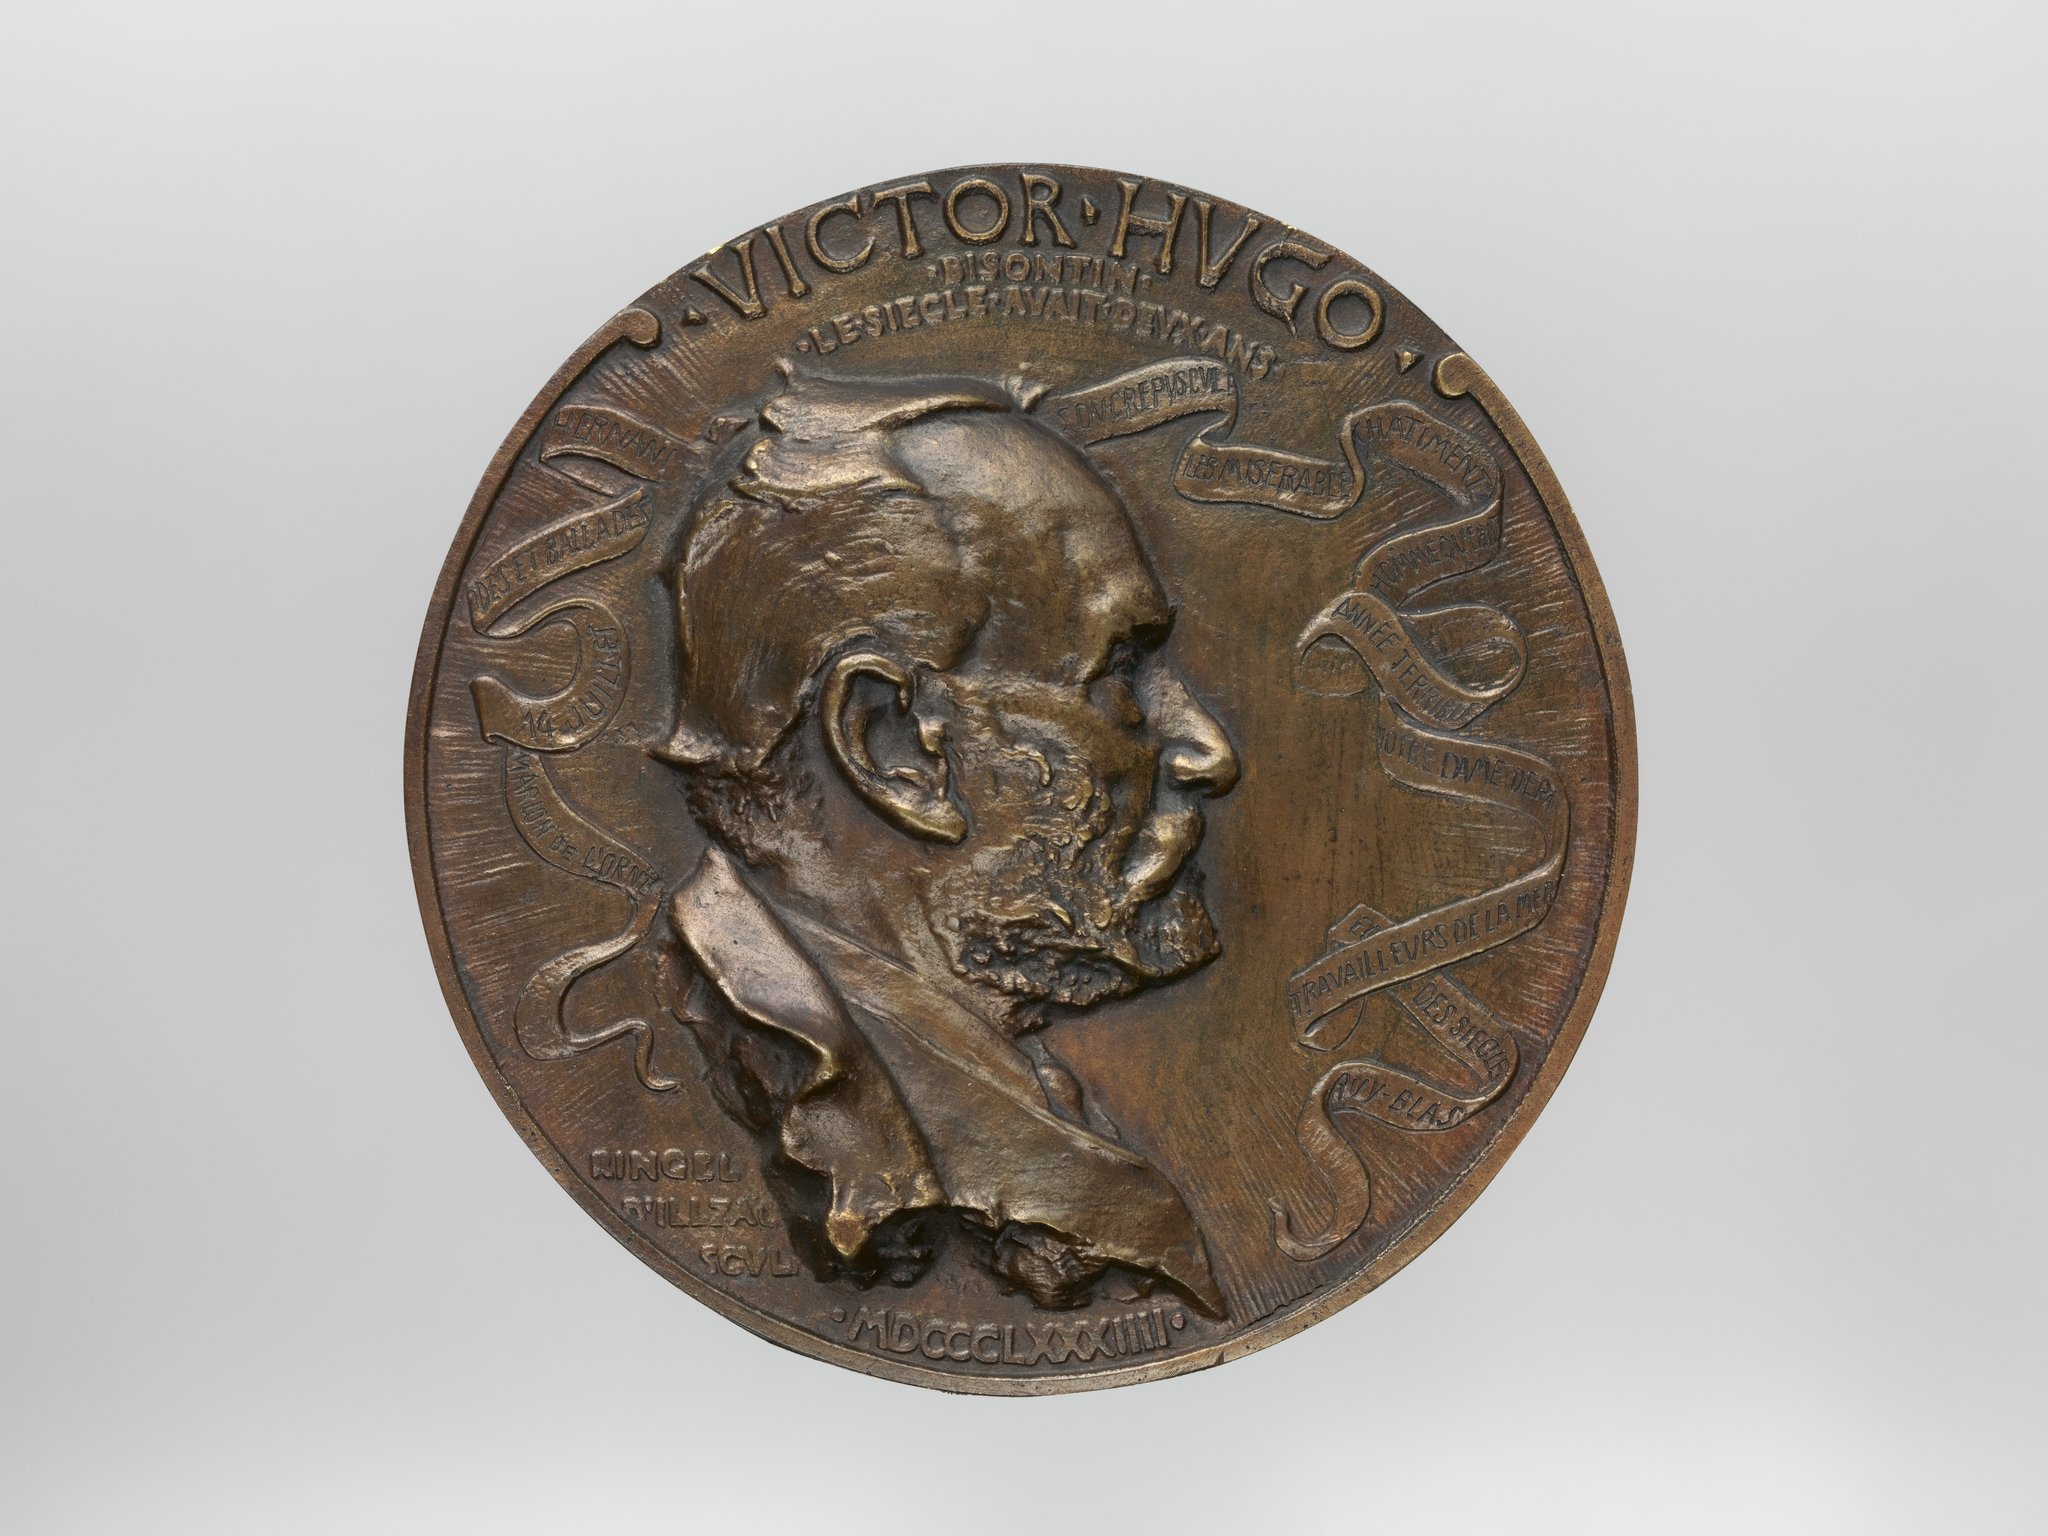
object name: medallion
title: Victor Hugo (1802–1885)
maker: jean-désiré ringel d'illzach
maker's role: artist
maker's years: 1847-1916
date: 1884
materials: bronze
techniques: casting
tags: men,profiles